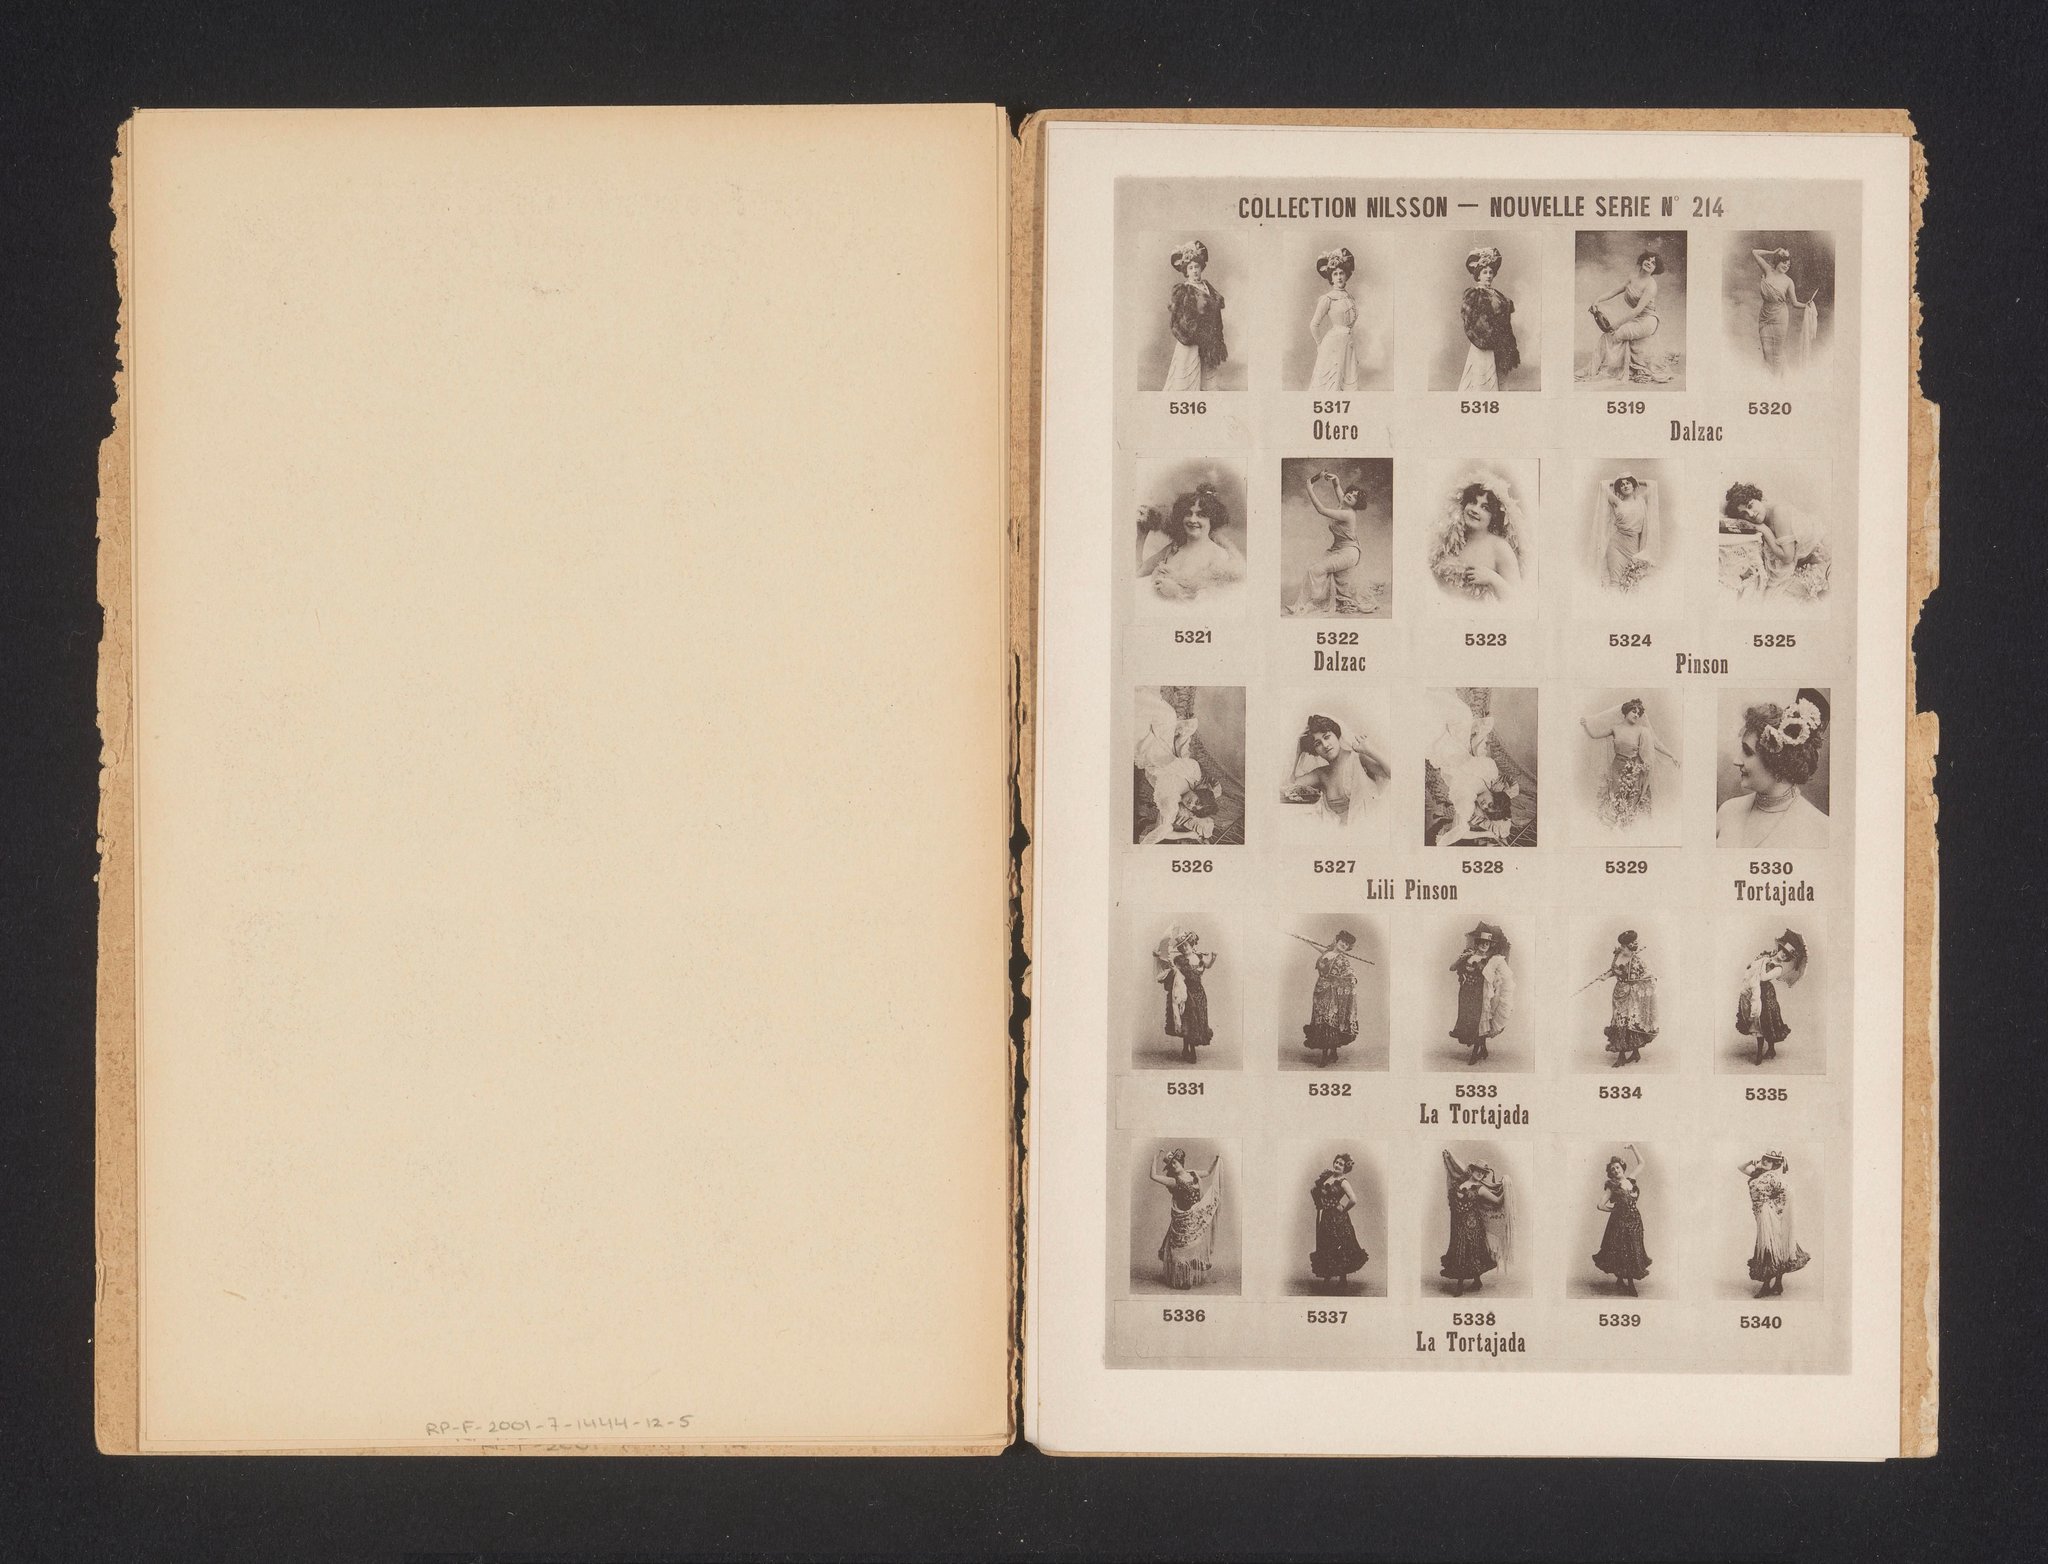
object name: photomechanical print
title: Collection Nilsson - Nouvelle Série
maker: Anonymous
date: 1894-1899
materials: paper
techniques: photograph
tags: historical persons - bb - woman, portrait of dancer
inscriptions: number: ‘No 214’